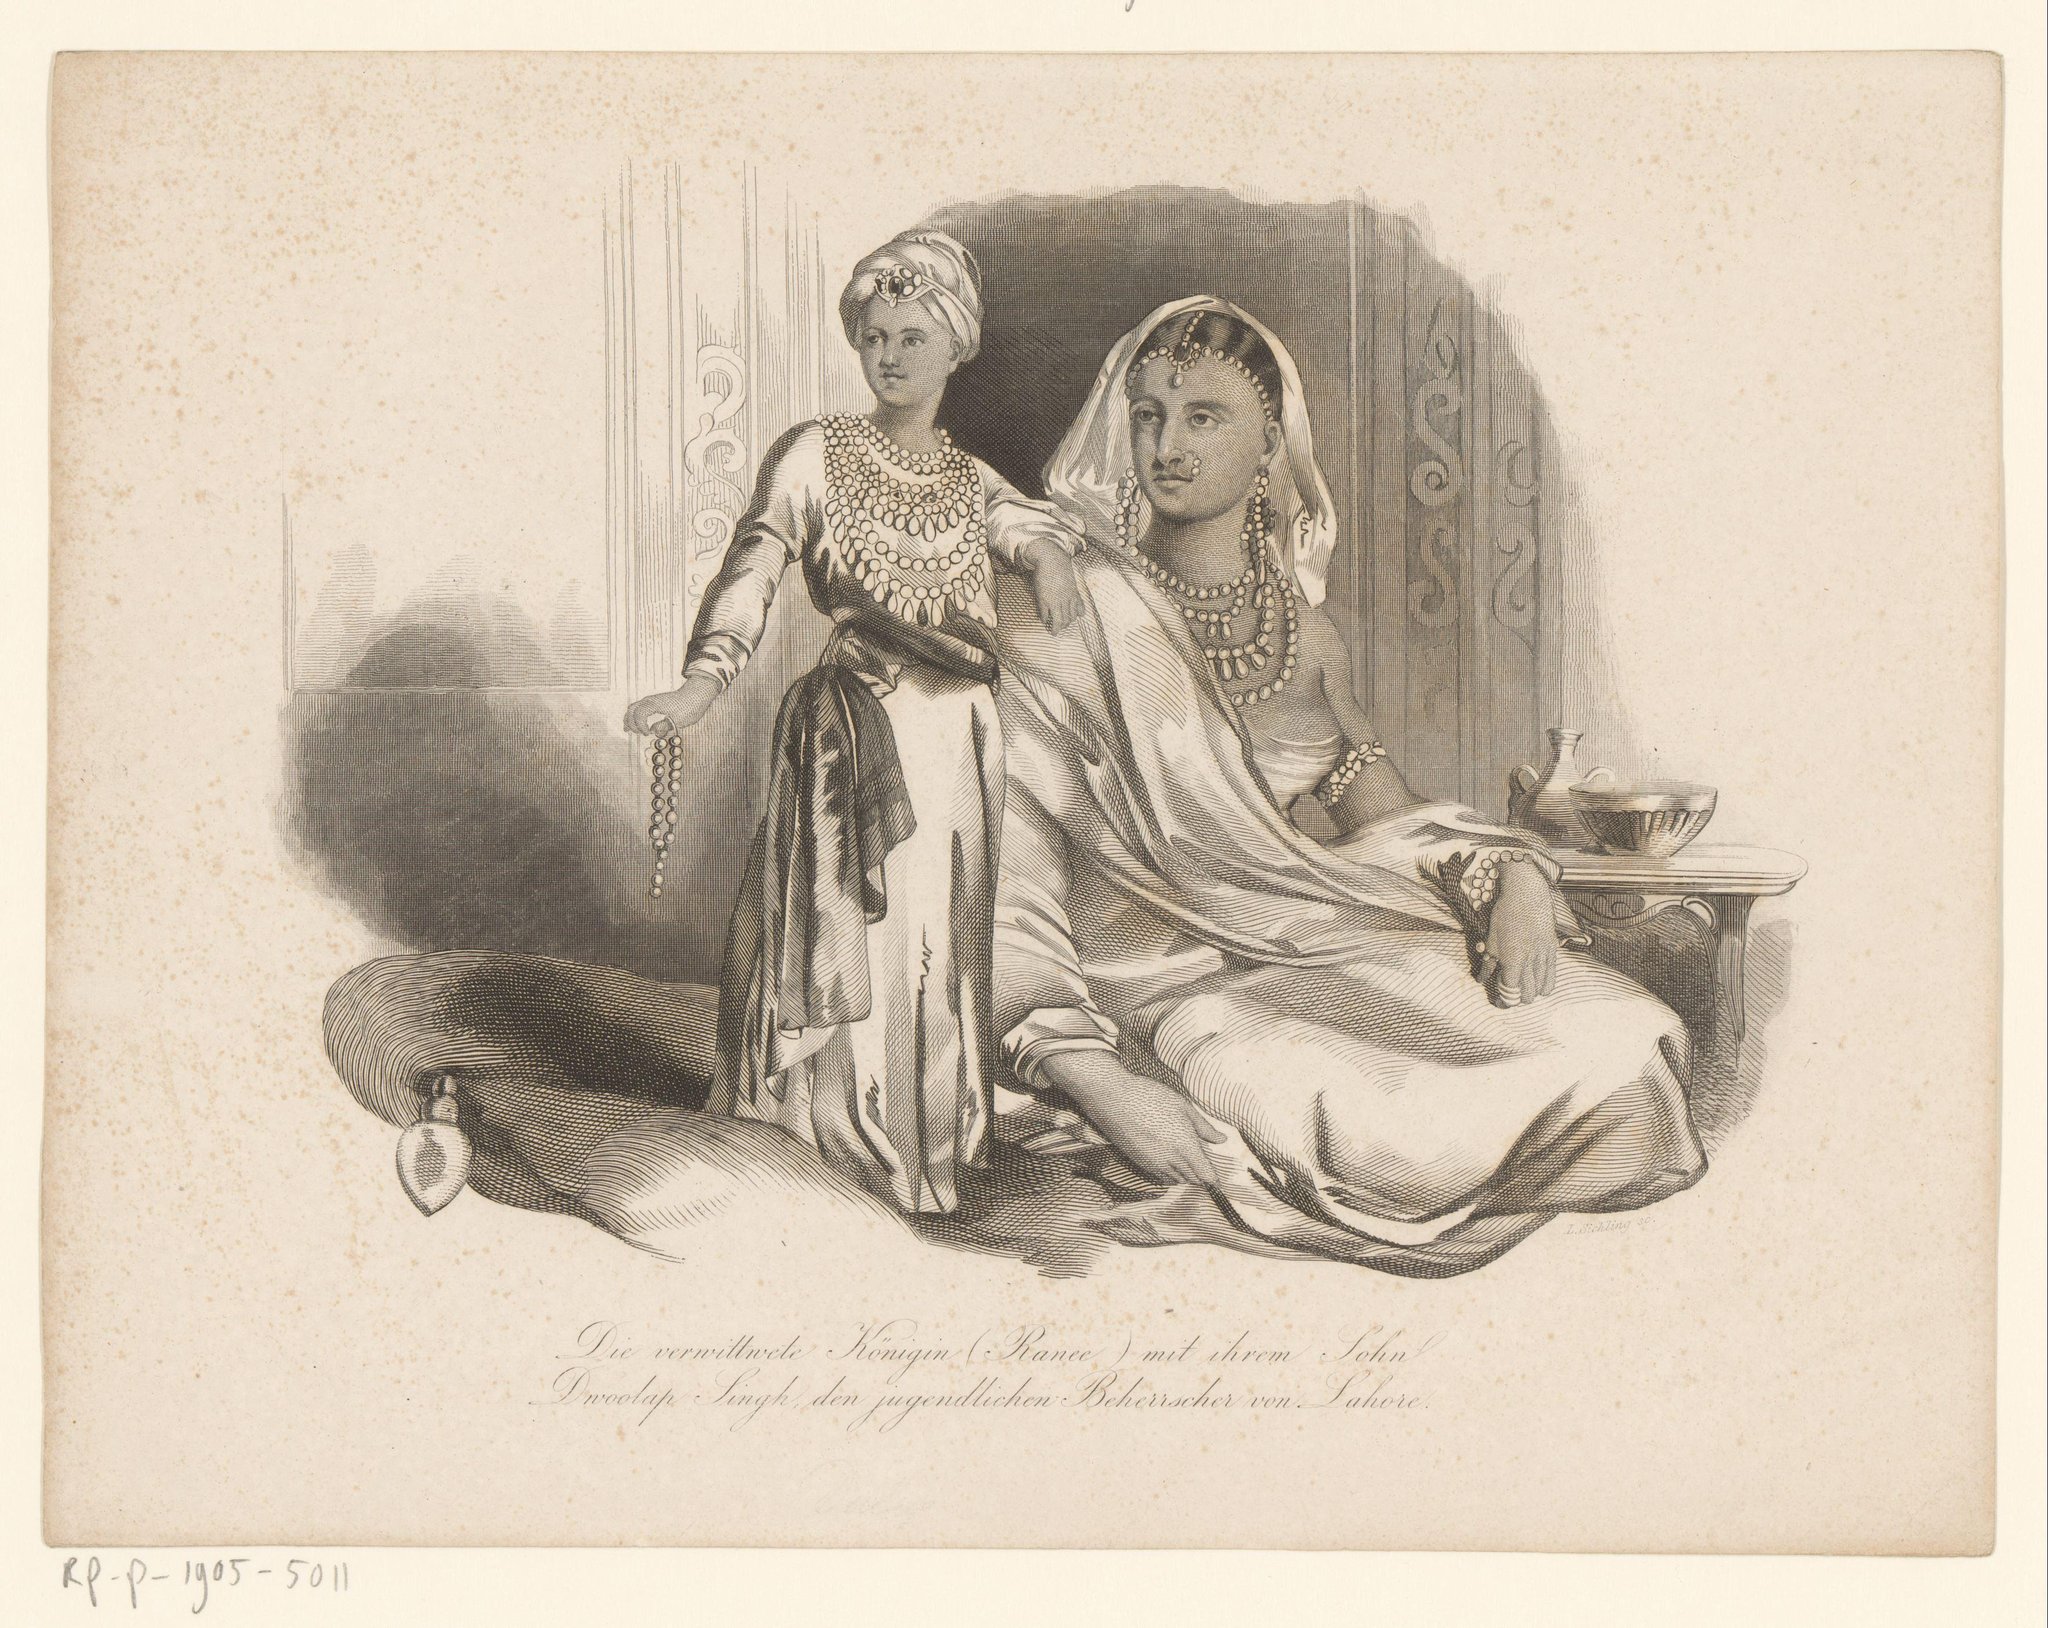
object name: print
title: Dubbelportret van koningin Ranee en prins Dwoolap Singh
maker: lazarus gottlieb sichling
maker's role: print maker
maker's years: 1812-1863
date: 1822-1863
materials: paper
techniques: engraving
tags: historical persons, ornaments, jewels, asiatic races and peoples: indians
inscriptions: collector's mark: Lugt 2228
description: Prent ook gebruikt in: The Pictorial Times. London: s.n., 14-04-1846.